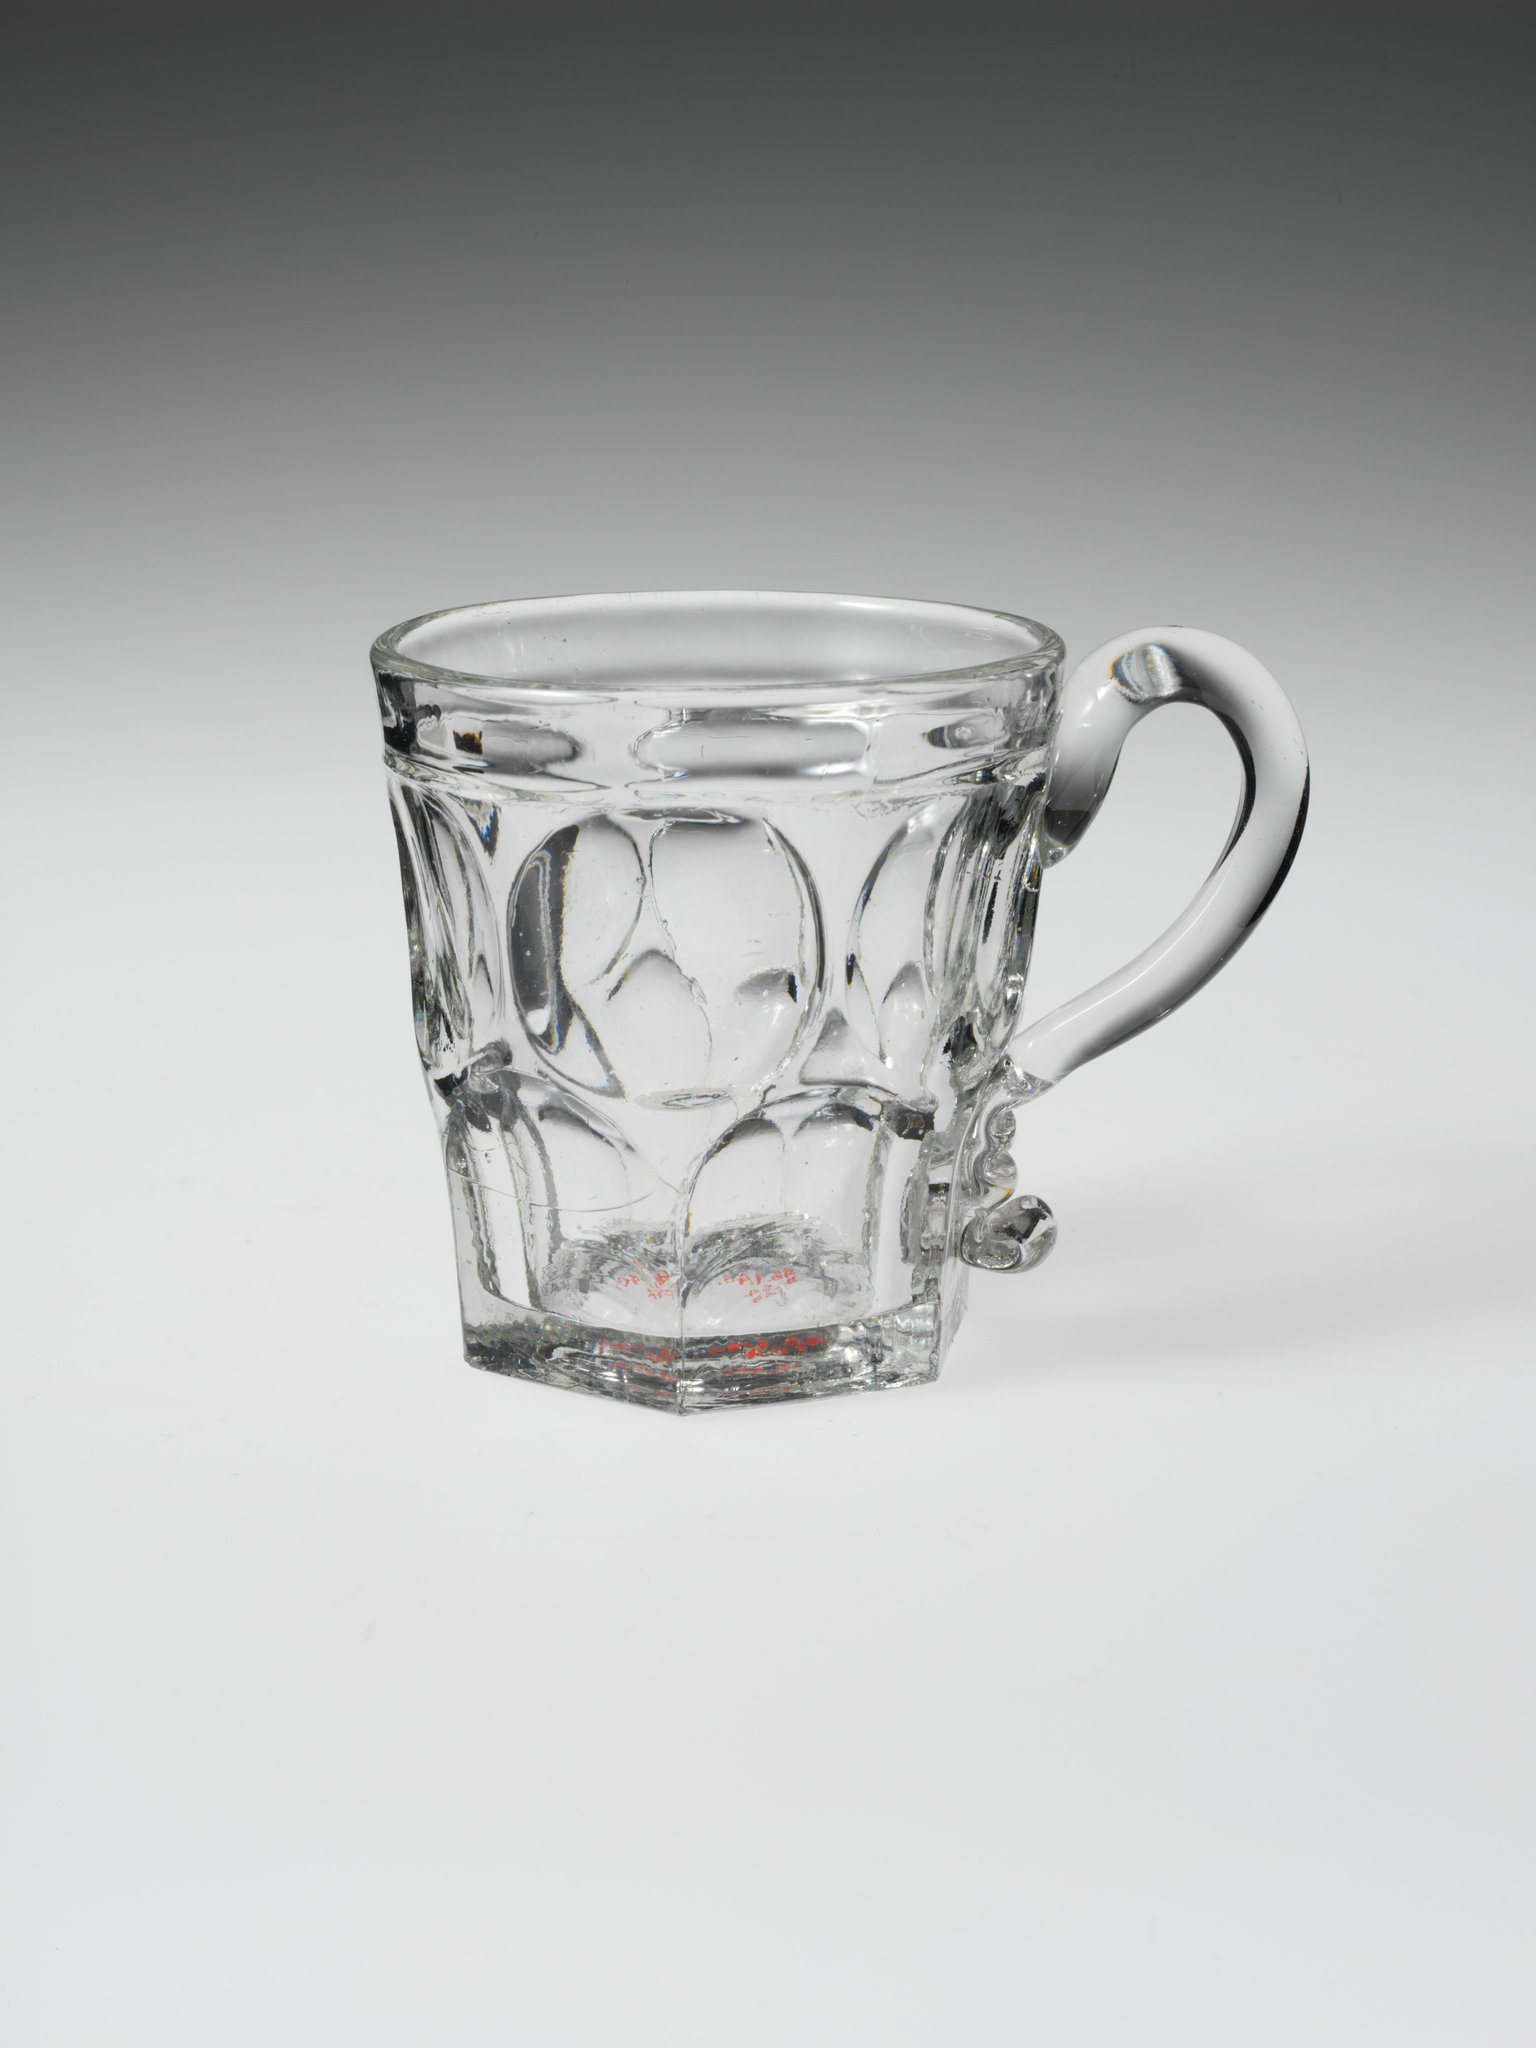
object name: mug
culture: american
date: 1830-1870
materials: glass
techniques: pressed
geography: united states